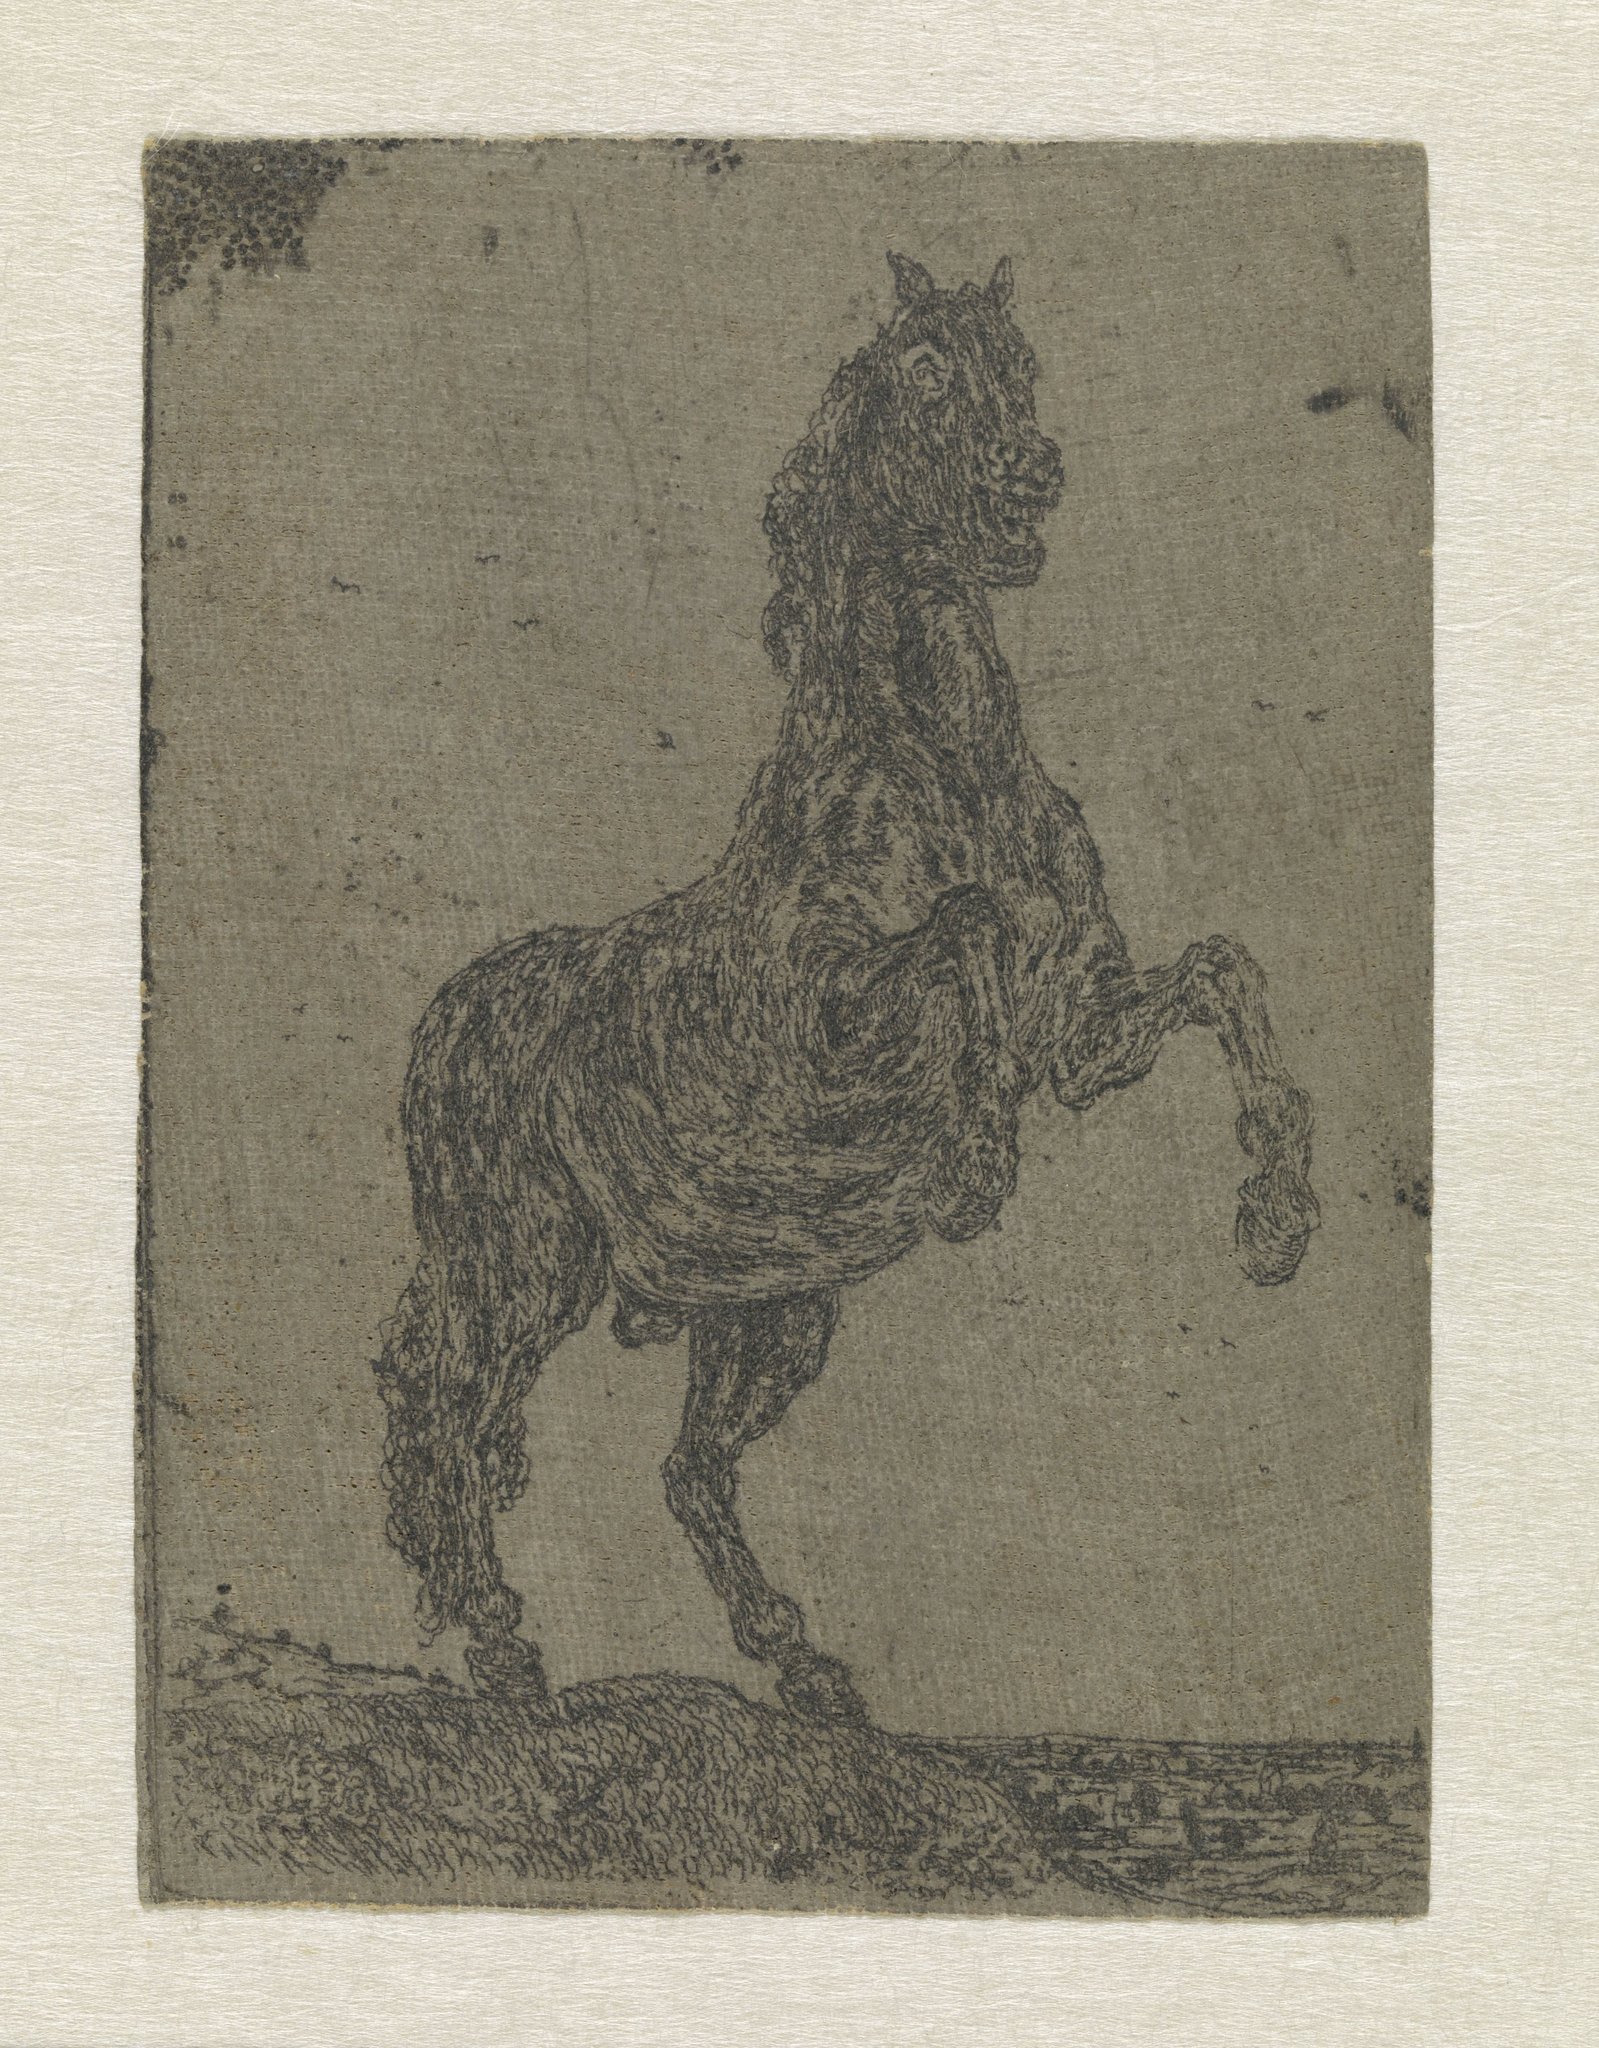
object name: print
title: A Rearing Horse before a Landscape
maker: hercules segers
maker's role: draughtsman, painter, print maker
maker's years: 1589-1640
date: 1618-1622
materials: linen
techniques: etching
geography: amsterdam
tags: rearing (horse in motion)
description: A fierce rearing horse towers above a tiny strip of landscape. Segers based this depiction of an animal – the only one he made! – on a print after a design by the Italian artist Antonio Tempesta.